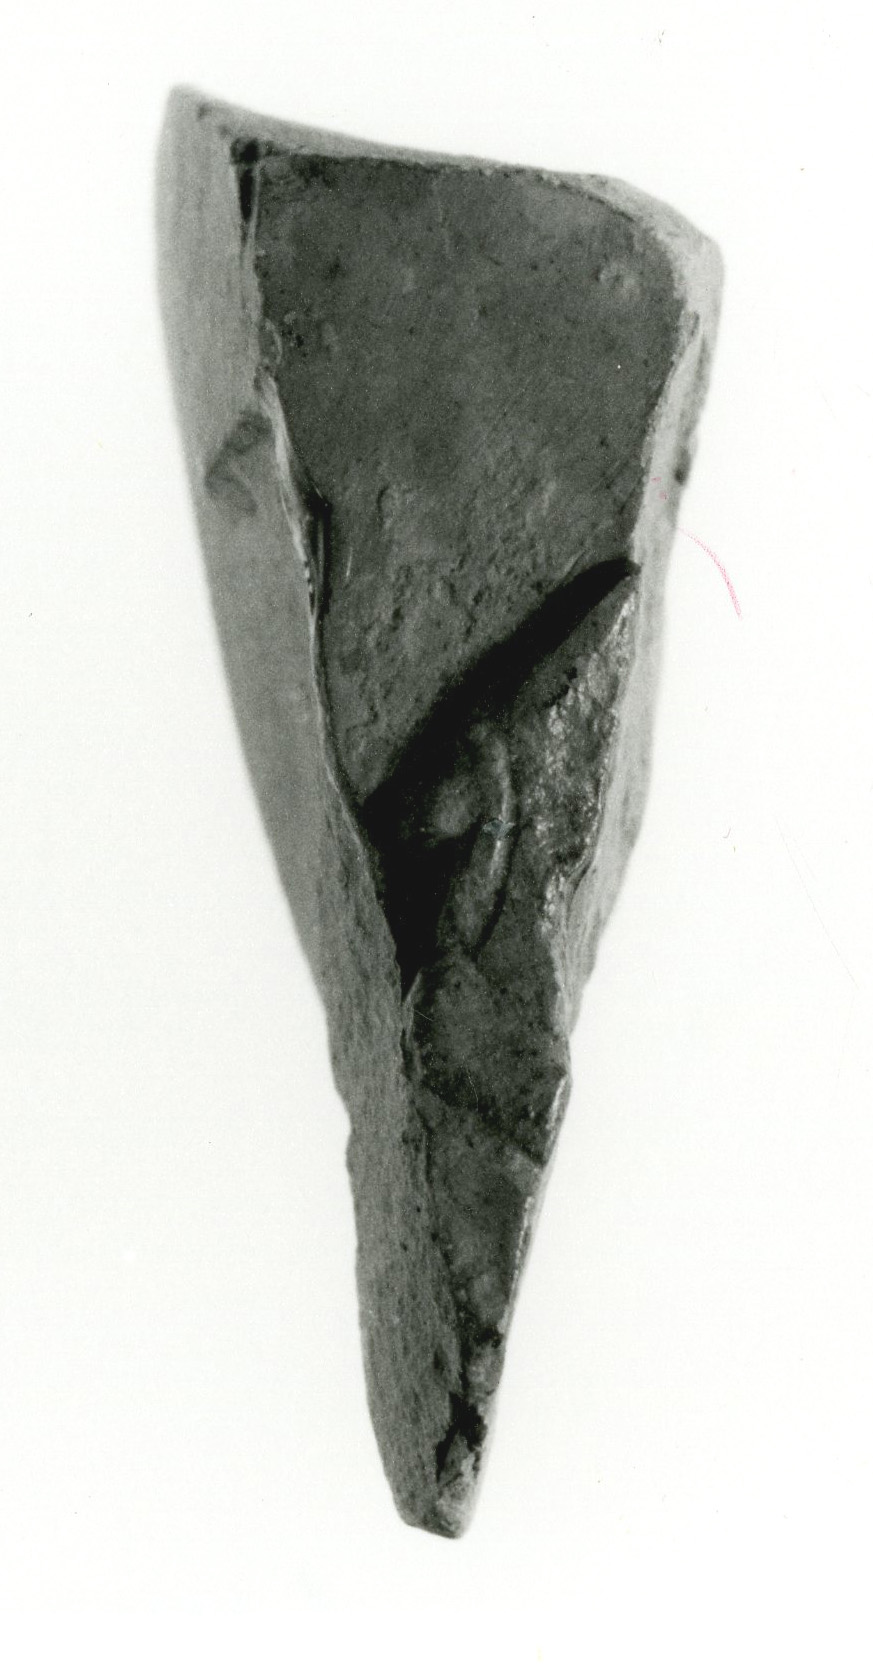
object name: relief, tomb of nespekashuty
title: Raised relief fragment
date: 664-610 BCE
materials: limestone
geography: egypt